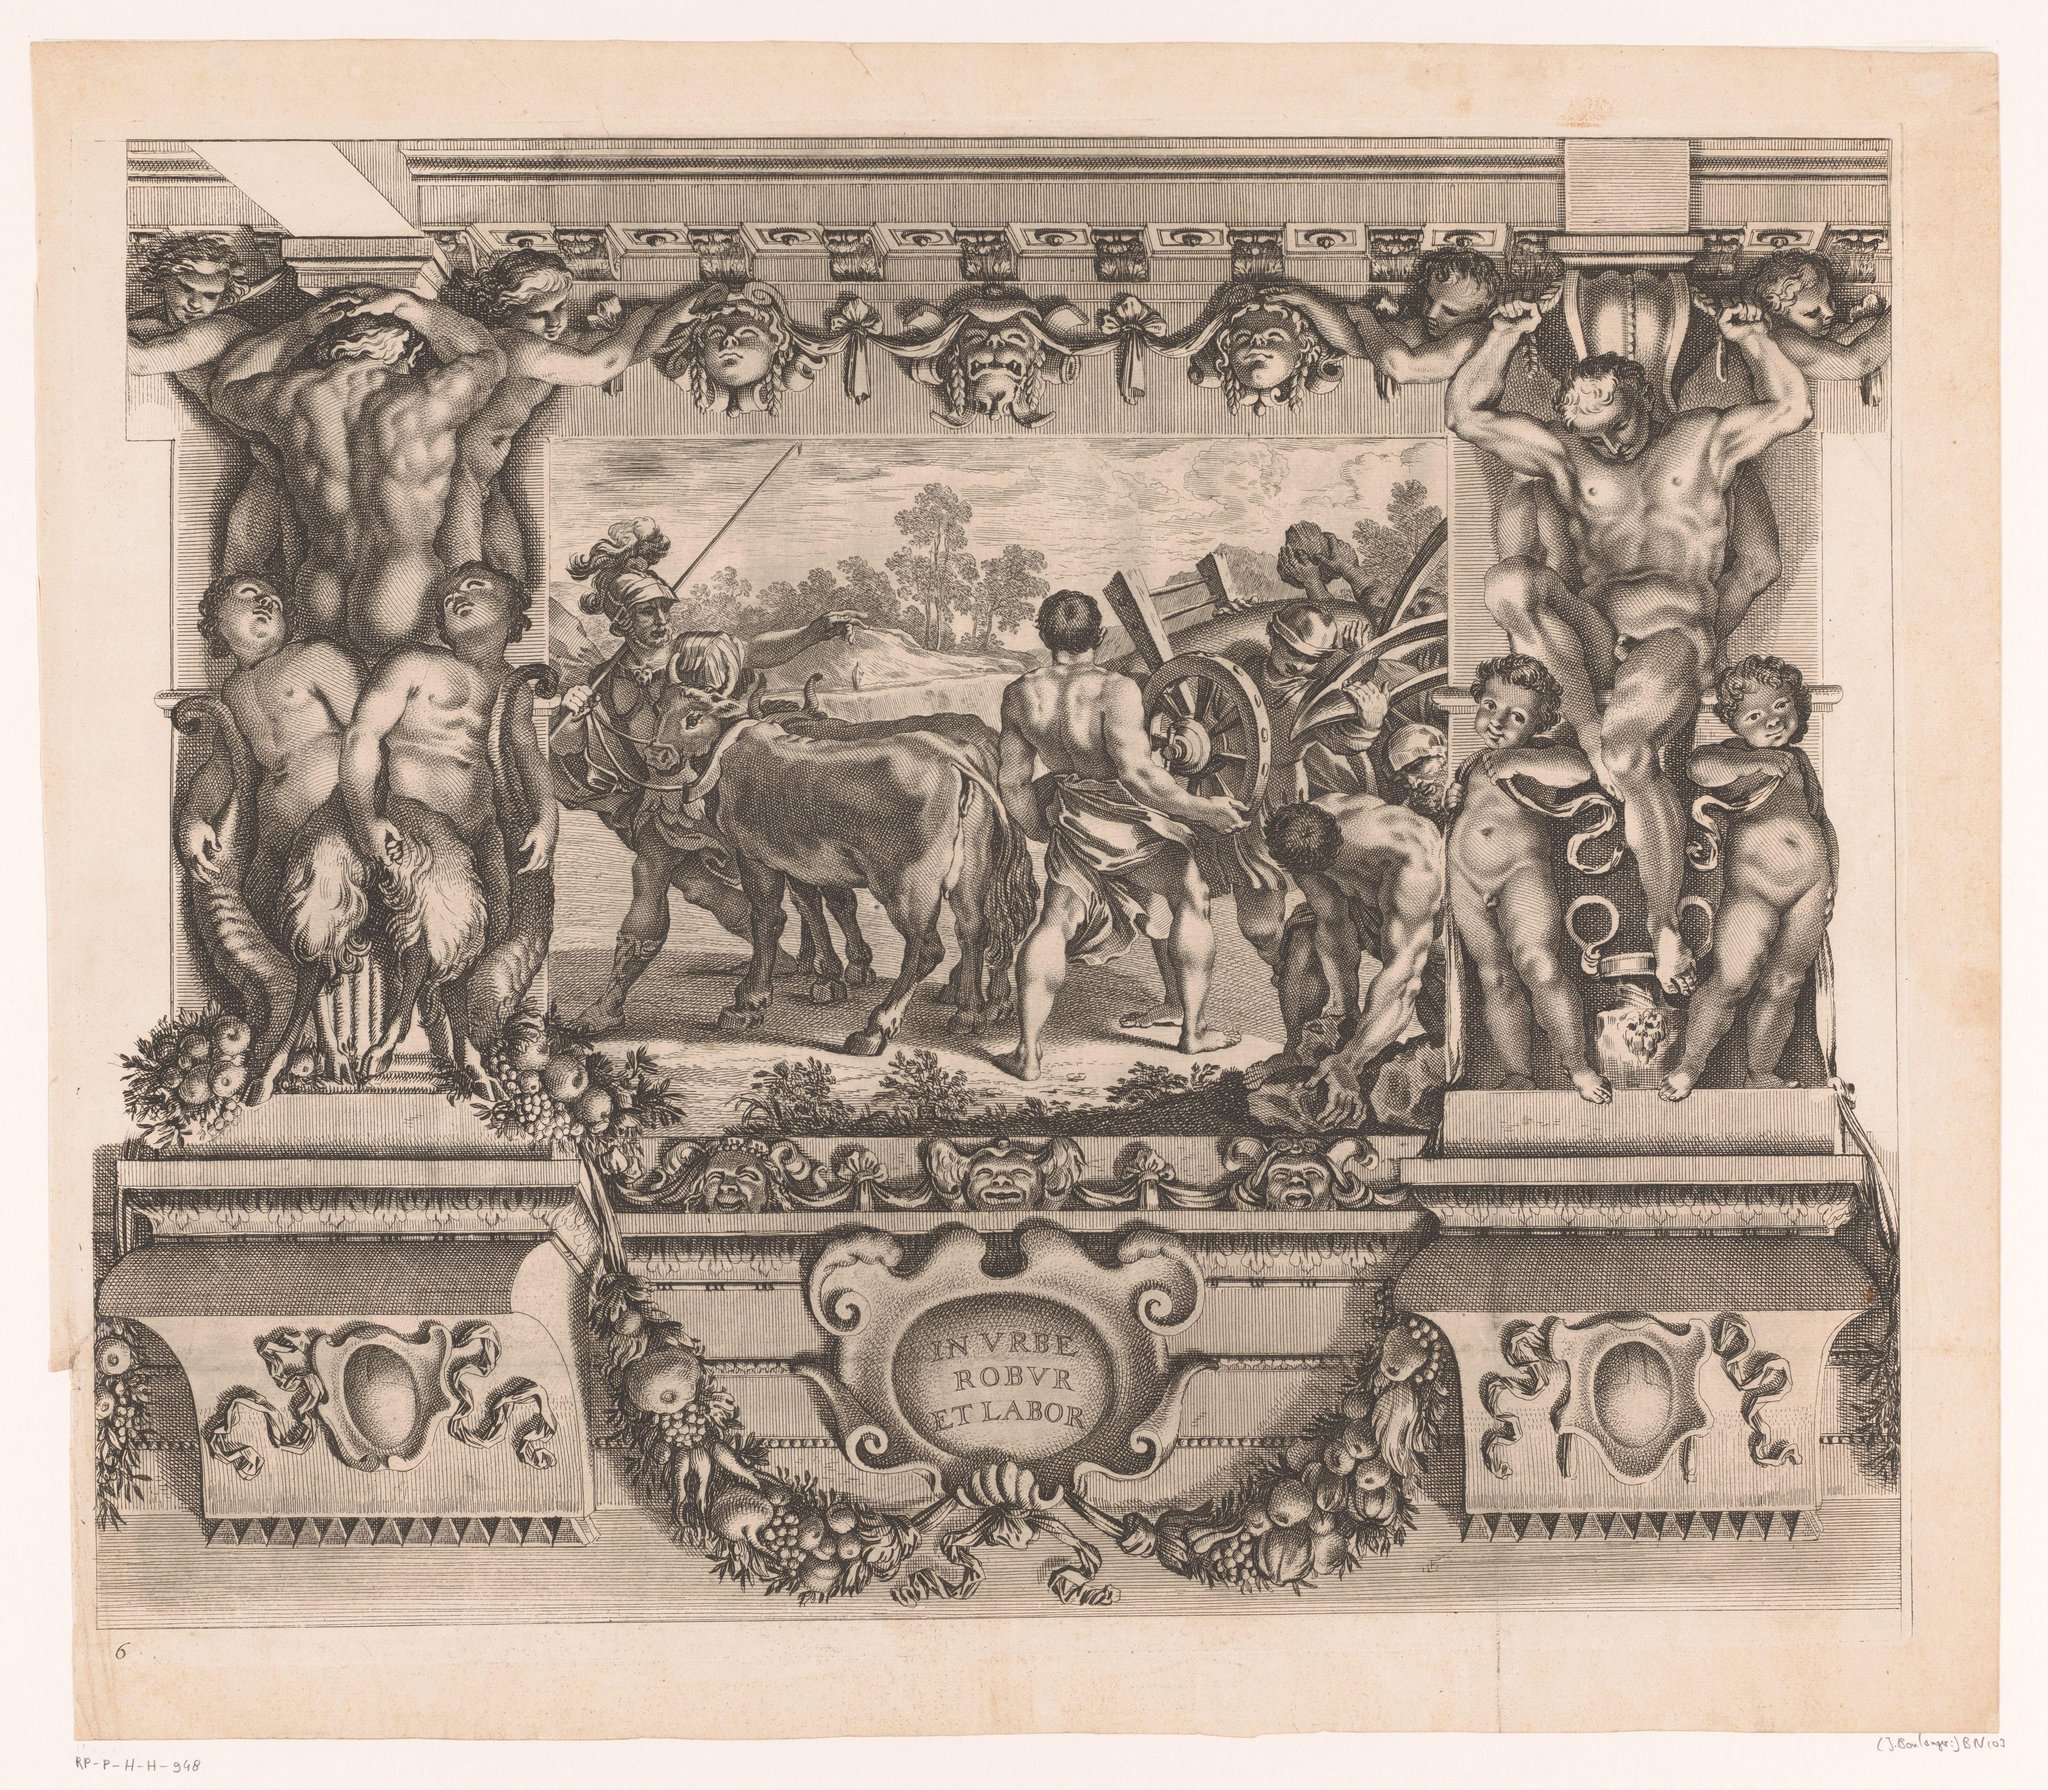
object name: print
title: Verhaal van Romulus en Remus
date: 1659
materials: paper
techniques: engraving, etching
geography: bologna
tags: romulus lays the foundation of rome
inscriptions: number: ‘137. 139.’, collector's mark: Lugt 11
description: Maakt deel uit van een 14-delige serie met scènes uit het verhaal van Romulus en Remus naar ontwerpen door de familie Carracci voor het Palazzo Magnani te Bologna. Prent 1 t/m 7 zijn in prent gebracht door Lepautre en Boulanger en prent 8 t/m 14 door De Châtillon.